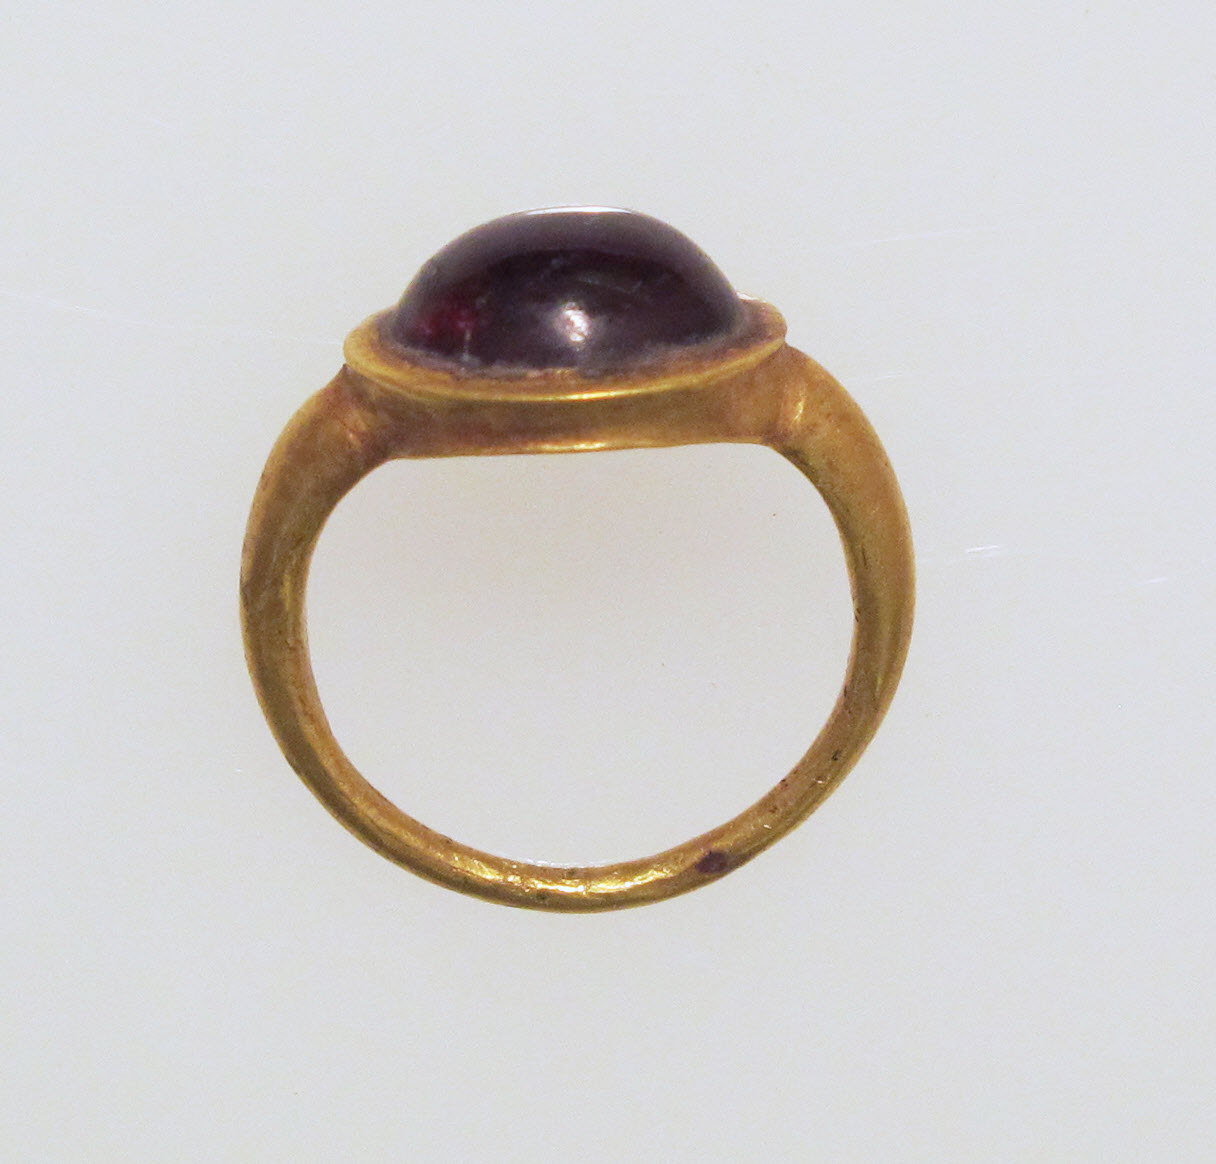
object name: ring with carbuncle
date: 7000 BCE-330 CE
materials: gold